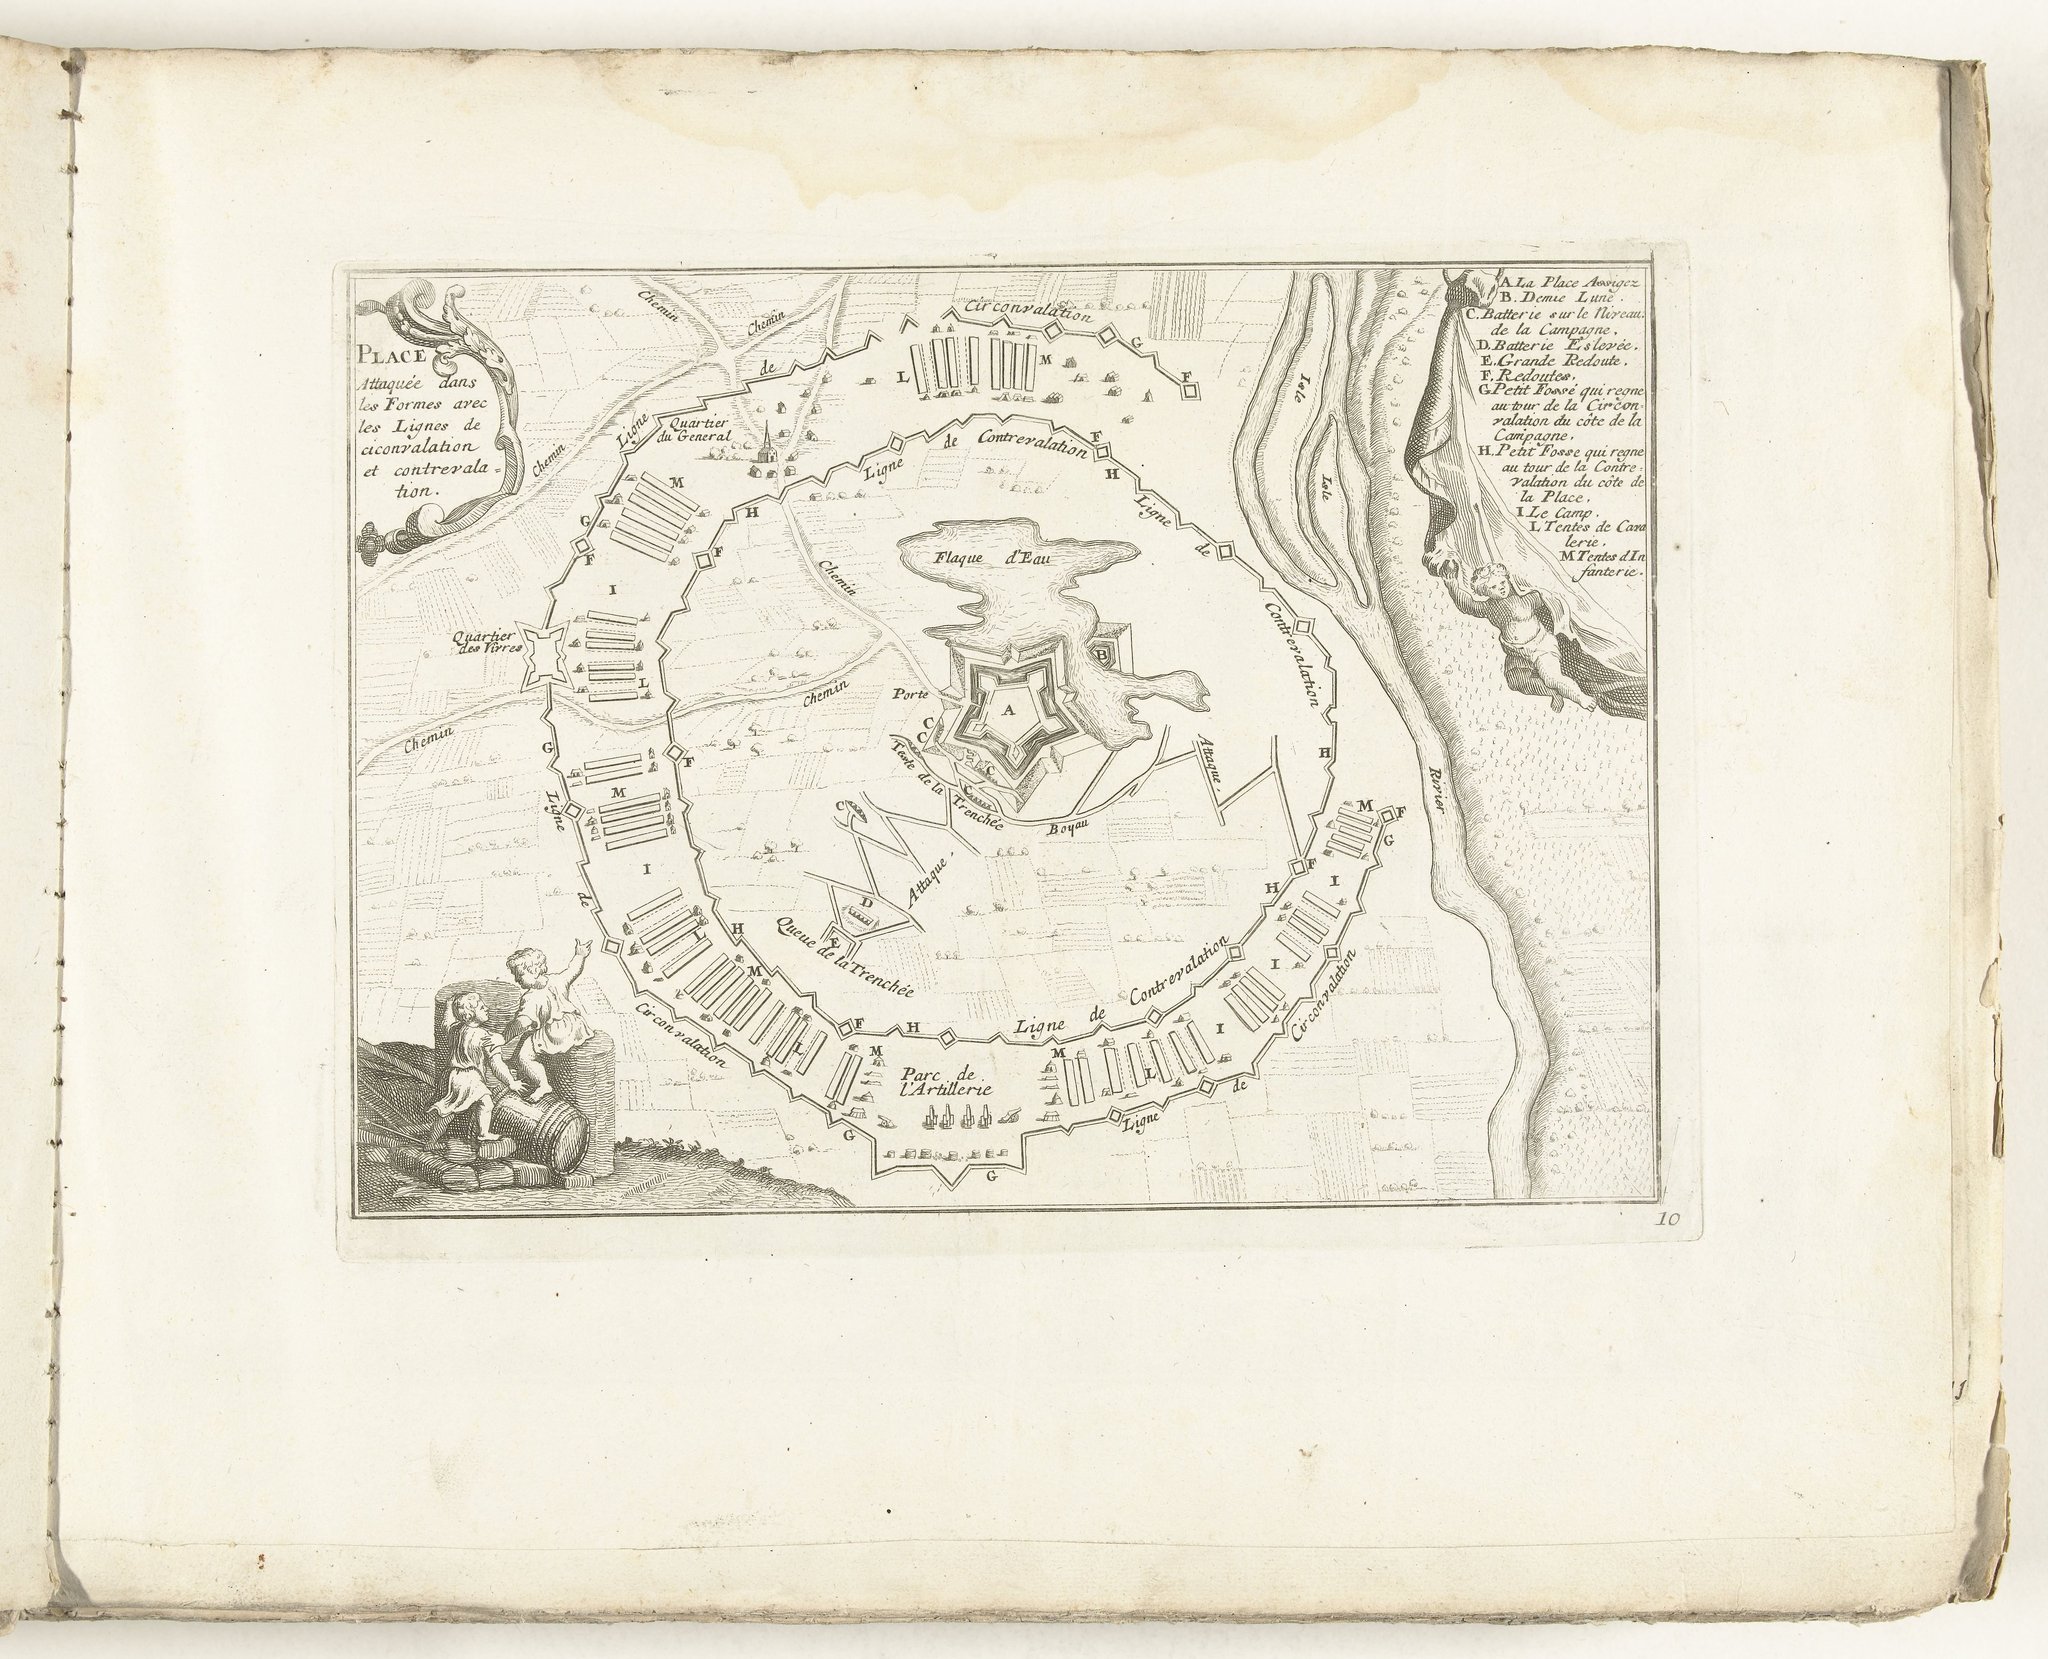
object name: print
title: Schematische voorstelling van een denkbeeldig beleg, ca. 1702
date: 1702-1703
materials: paper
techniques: etching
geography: northern netherlands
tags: fortifications, military engineering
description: Schematische voorstelling van een denkbeeldig beleg. Plaat nr. 10 in het prentwerk bestaande in totaal uit 276 genummerde platen van vermaarde sterke steden en vestingen in het kader van de Spaanse Successieoorlog. Voor het merendeel zijn deze platen gekopieerd naar de anonieme Franse platen: in Les forces de l'Europe en in: Le theatre de la guerre, dans les Pays-Bas, beide oorspronkelijk uitgegeven door Nicolas de Fer te Parijs (1693-1697) in het kader van de Negenjarige Oorlog. Titel en opschriften in het Frans.